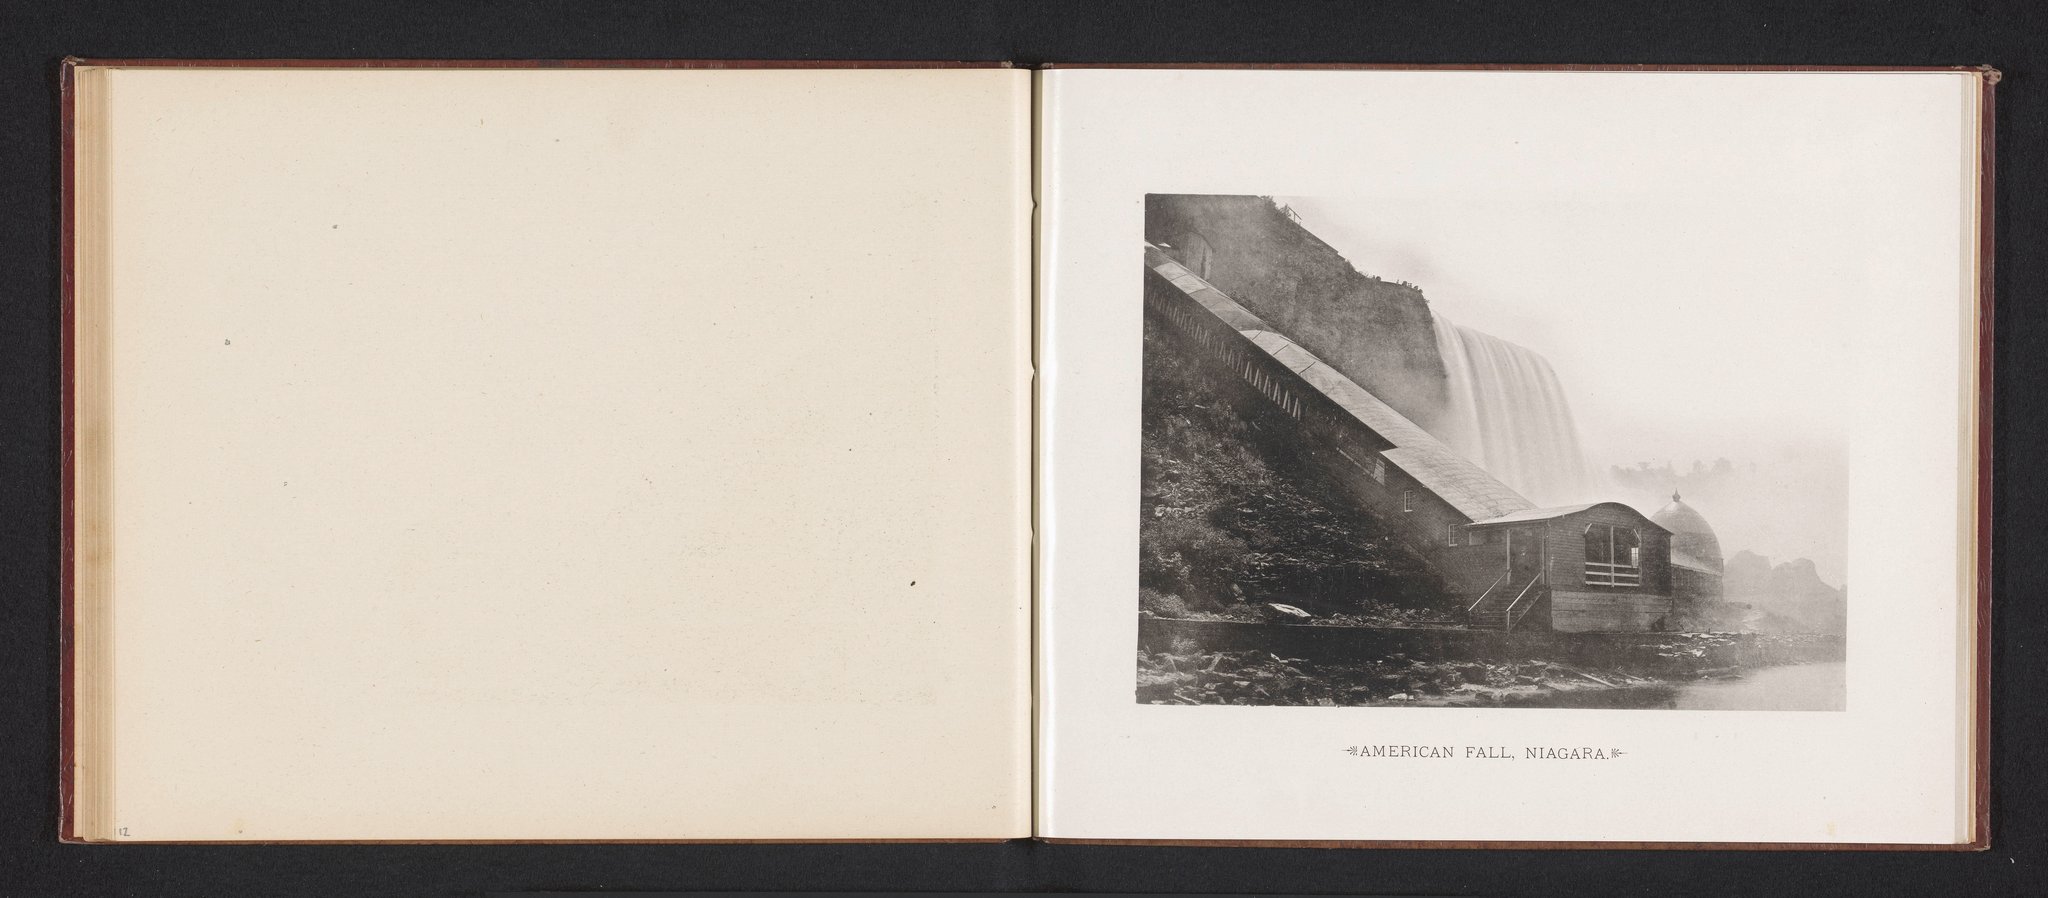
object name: page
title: Gezicht op de American Falls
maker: Anonymous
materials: paper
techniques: photograph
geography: american falls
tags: waterfall